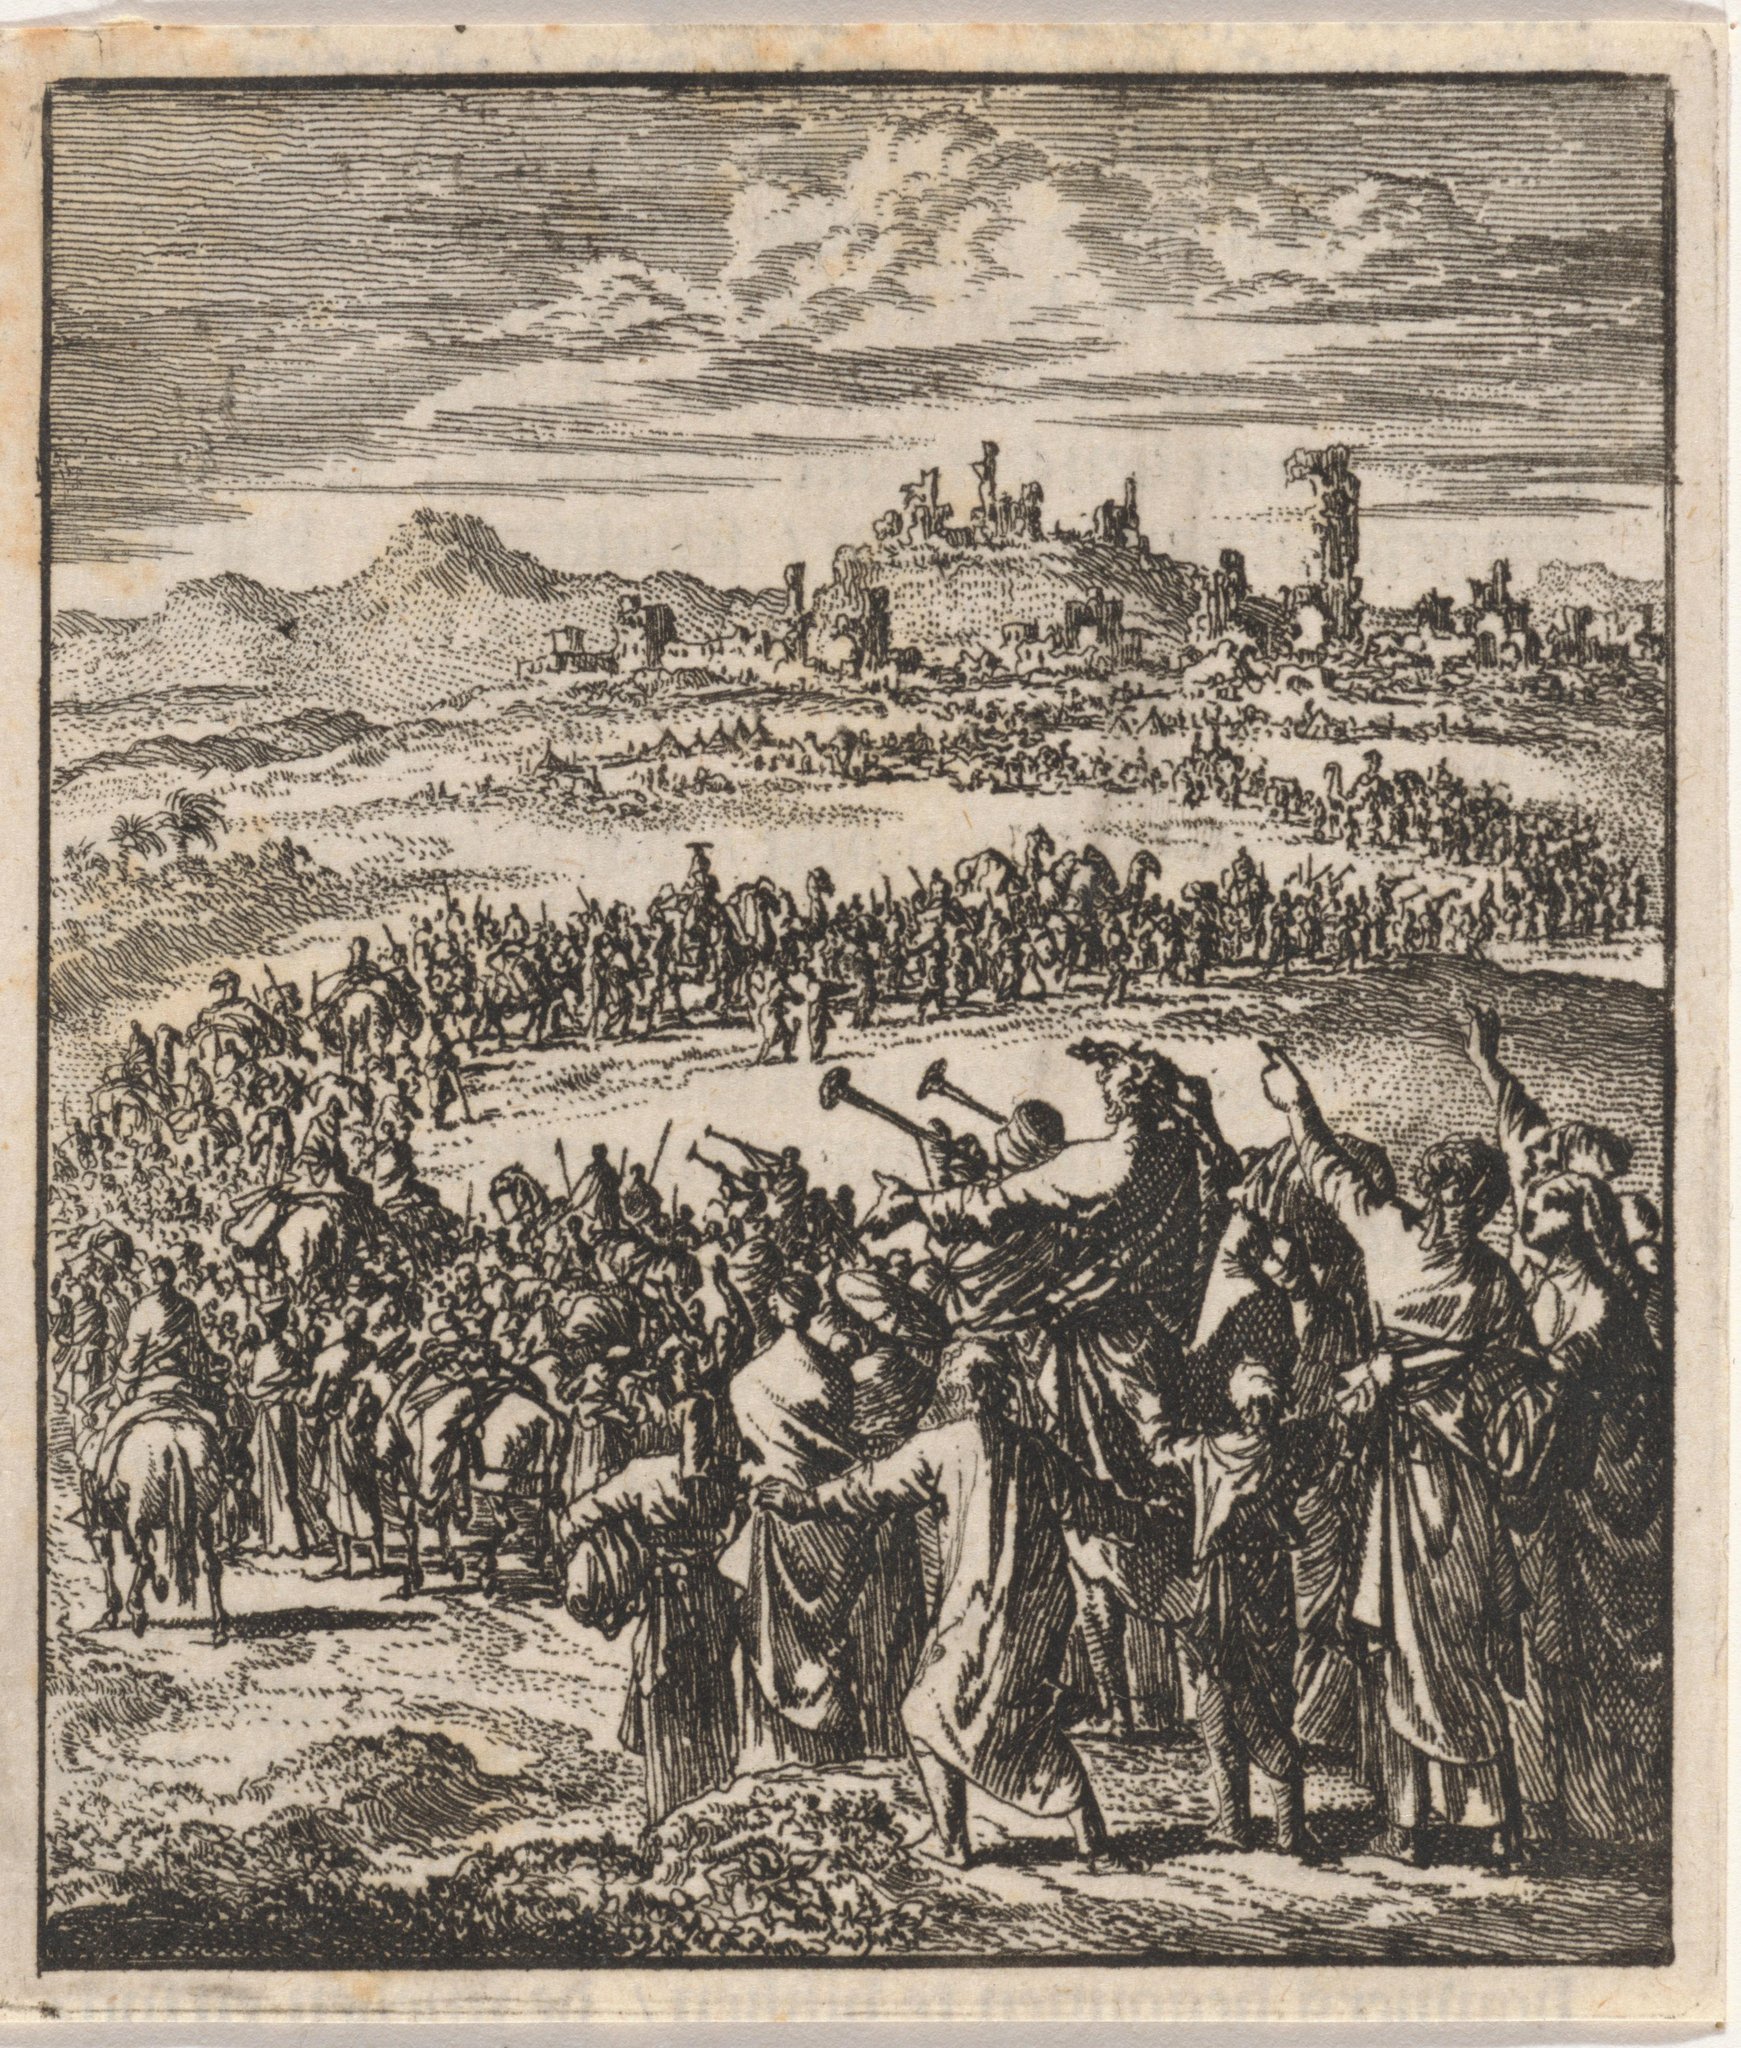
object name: book illustration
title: Terugkeer uit de Babylonische ballingschap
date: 1706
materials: paper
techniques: etching, letterpress printing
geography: amsterdam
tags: return from the babylonian captivity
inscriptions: collector's mark: Lugt 2228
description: Illustratie voor: Schabaalje, Jean Philipsz. De vermeerderde lust-hof des gemoeds. Amsterdam: Jan Rieuwertsz. (II) en Barent Visscher, 1706, p. 277.